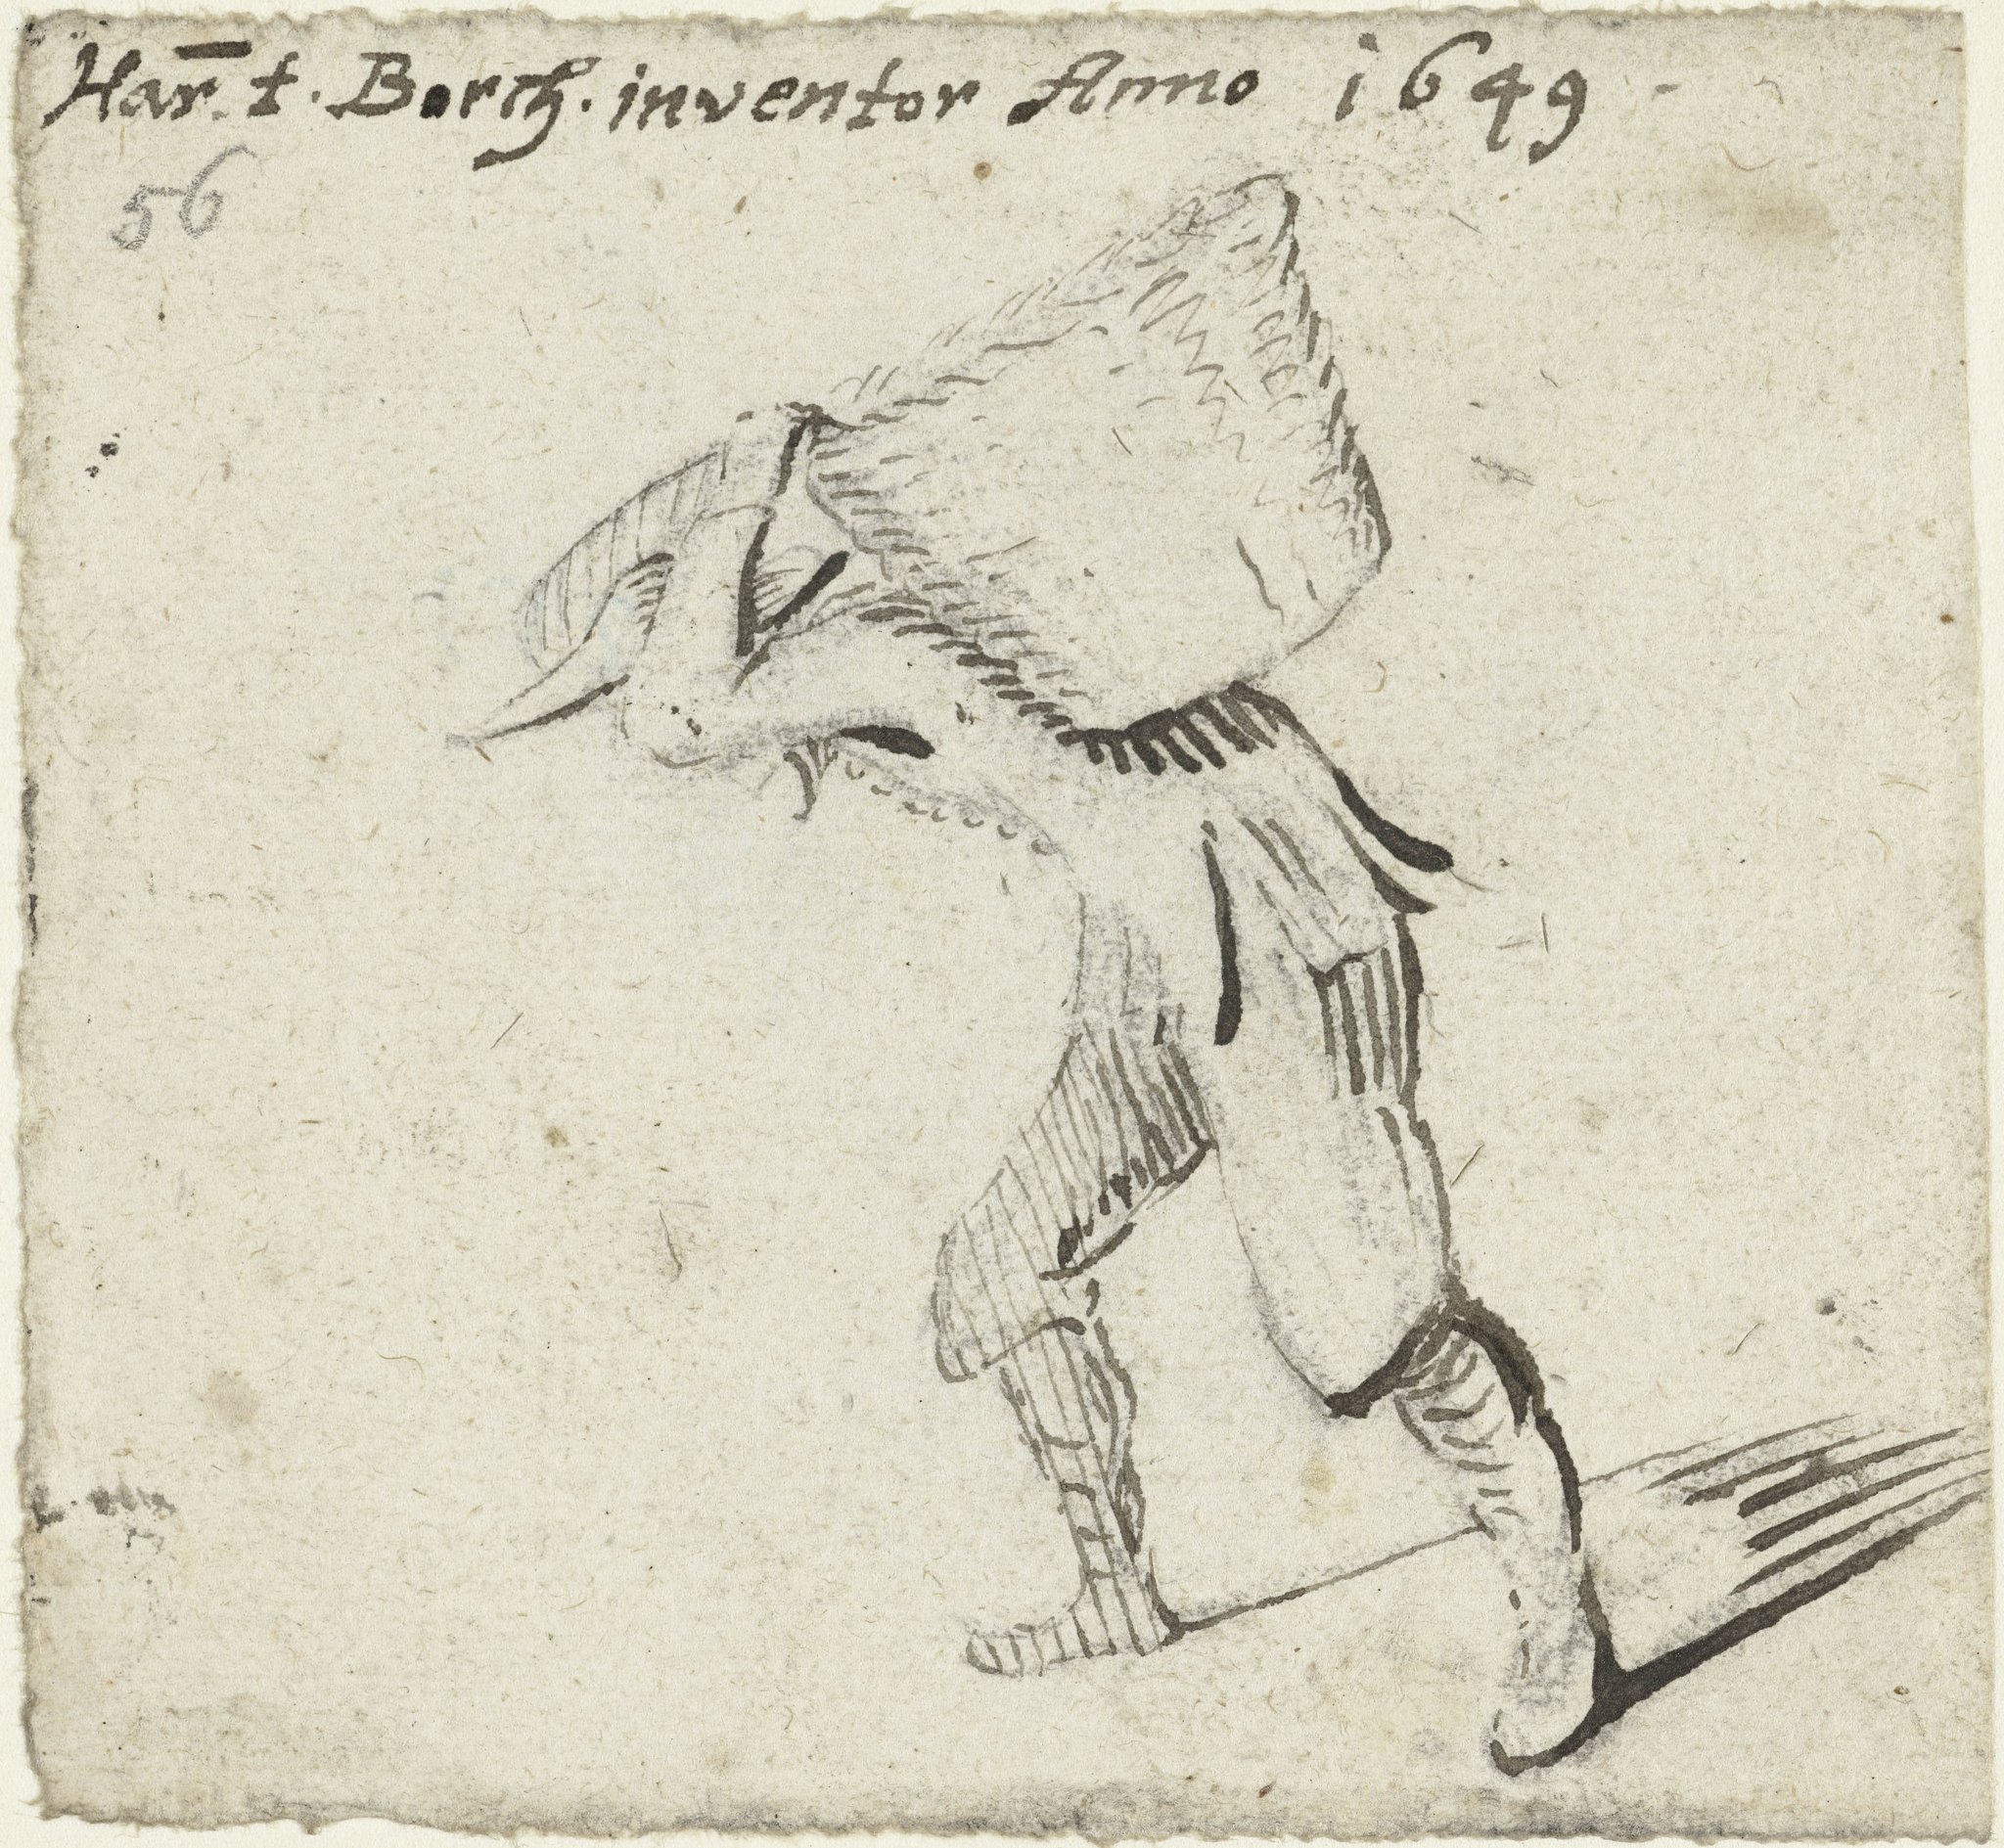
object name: drawing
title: Man die een mand op zijn schouders draagt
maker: harmen ter borch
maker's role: draughtsman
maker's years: 1638-1677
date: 1649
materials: chalk, ink, paper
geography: zwolle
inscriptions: annotation: ‘Har[men].t.Borch. Inventor Anno 1649’